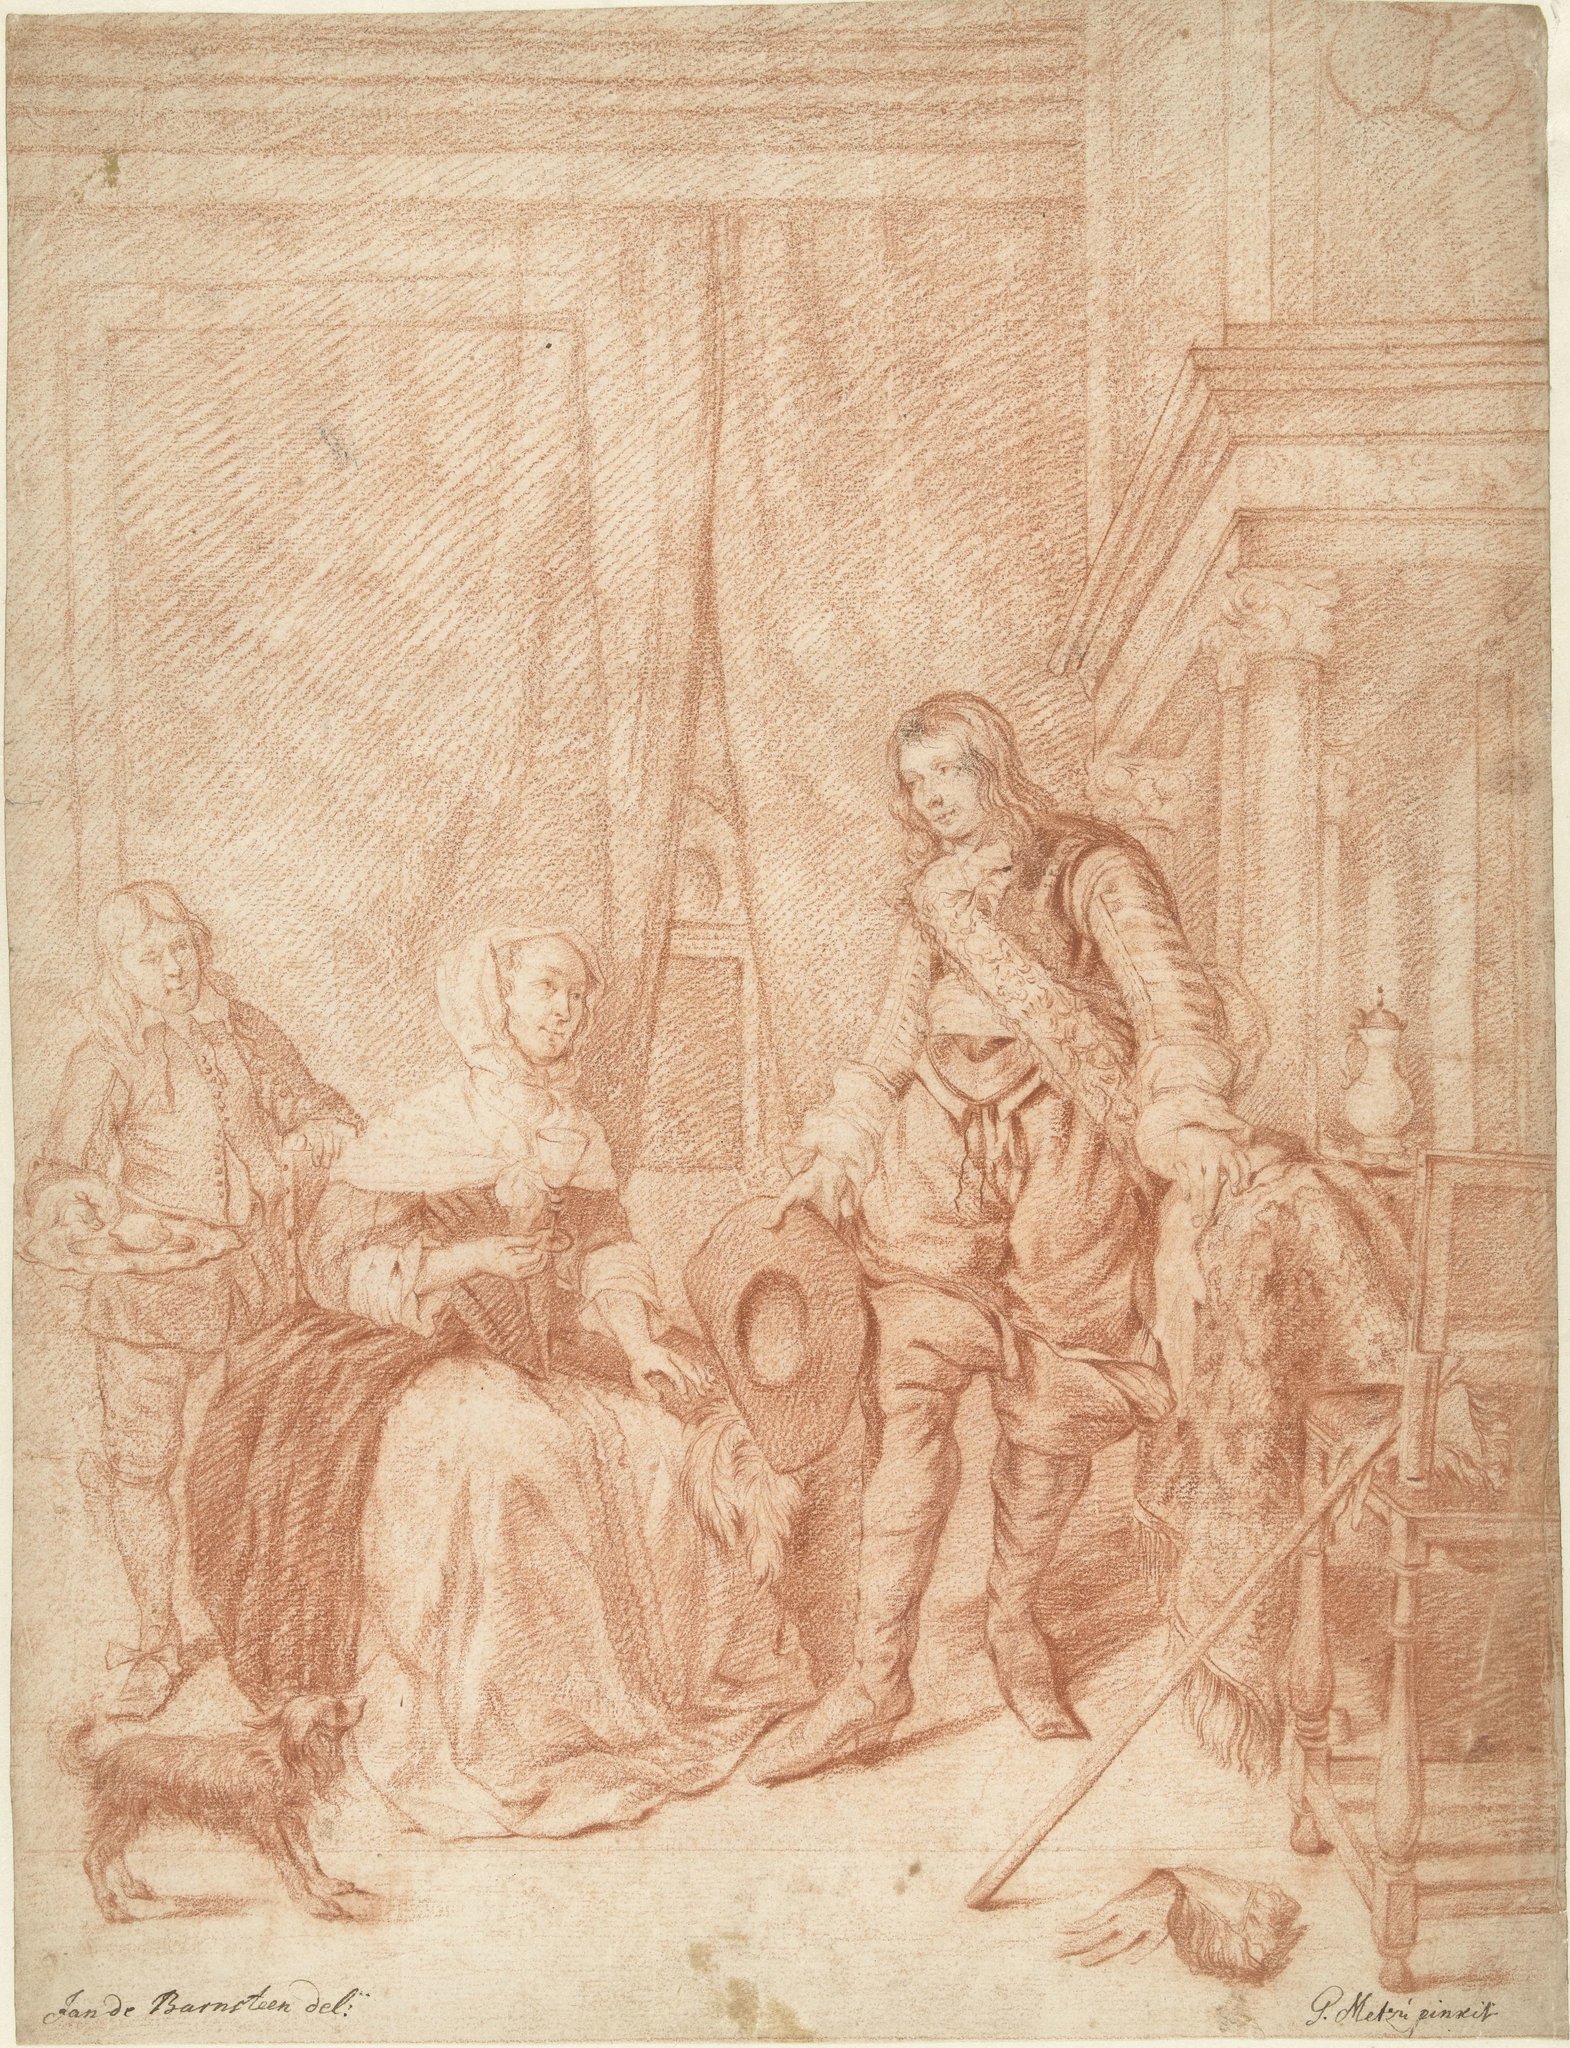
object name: drawing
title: Staande jongeman, zittende vrouw en een dienstbode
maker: jan de barnsteen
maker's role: draughtsman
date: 1700-1800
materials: chalk, paper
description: Staande jongeman voor een zittende vrouw, links een dienstbode.